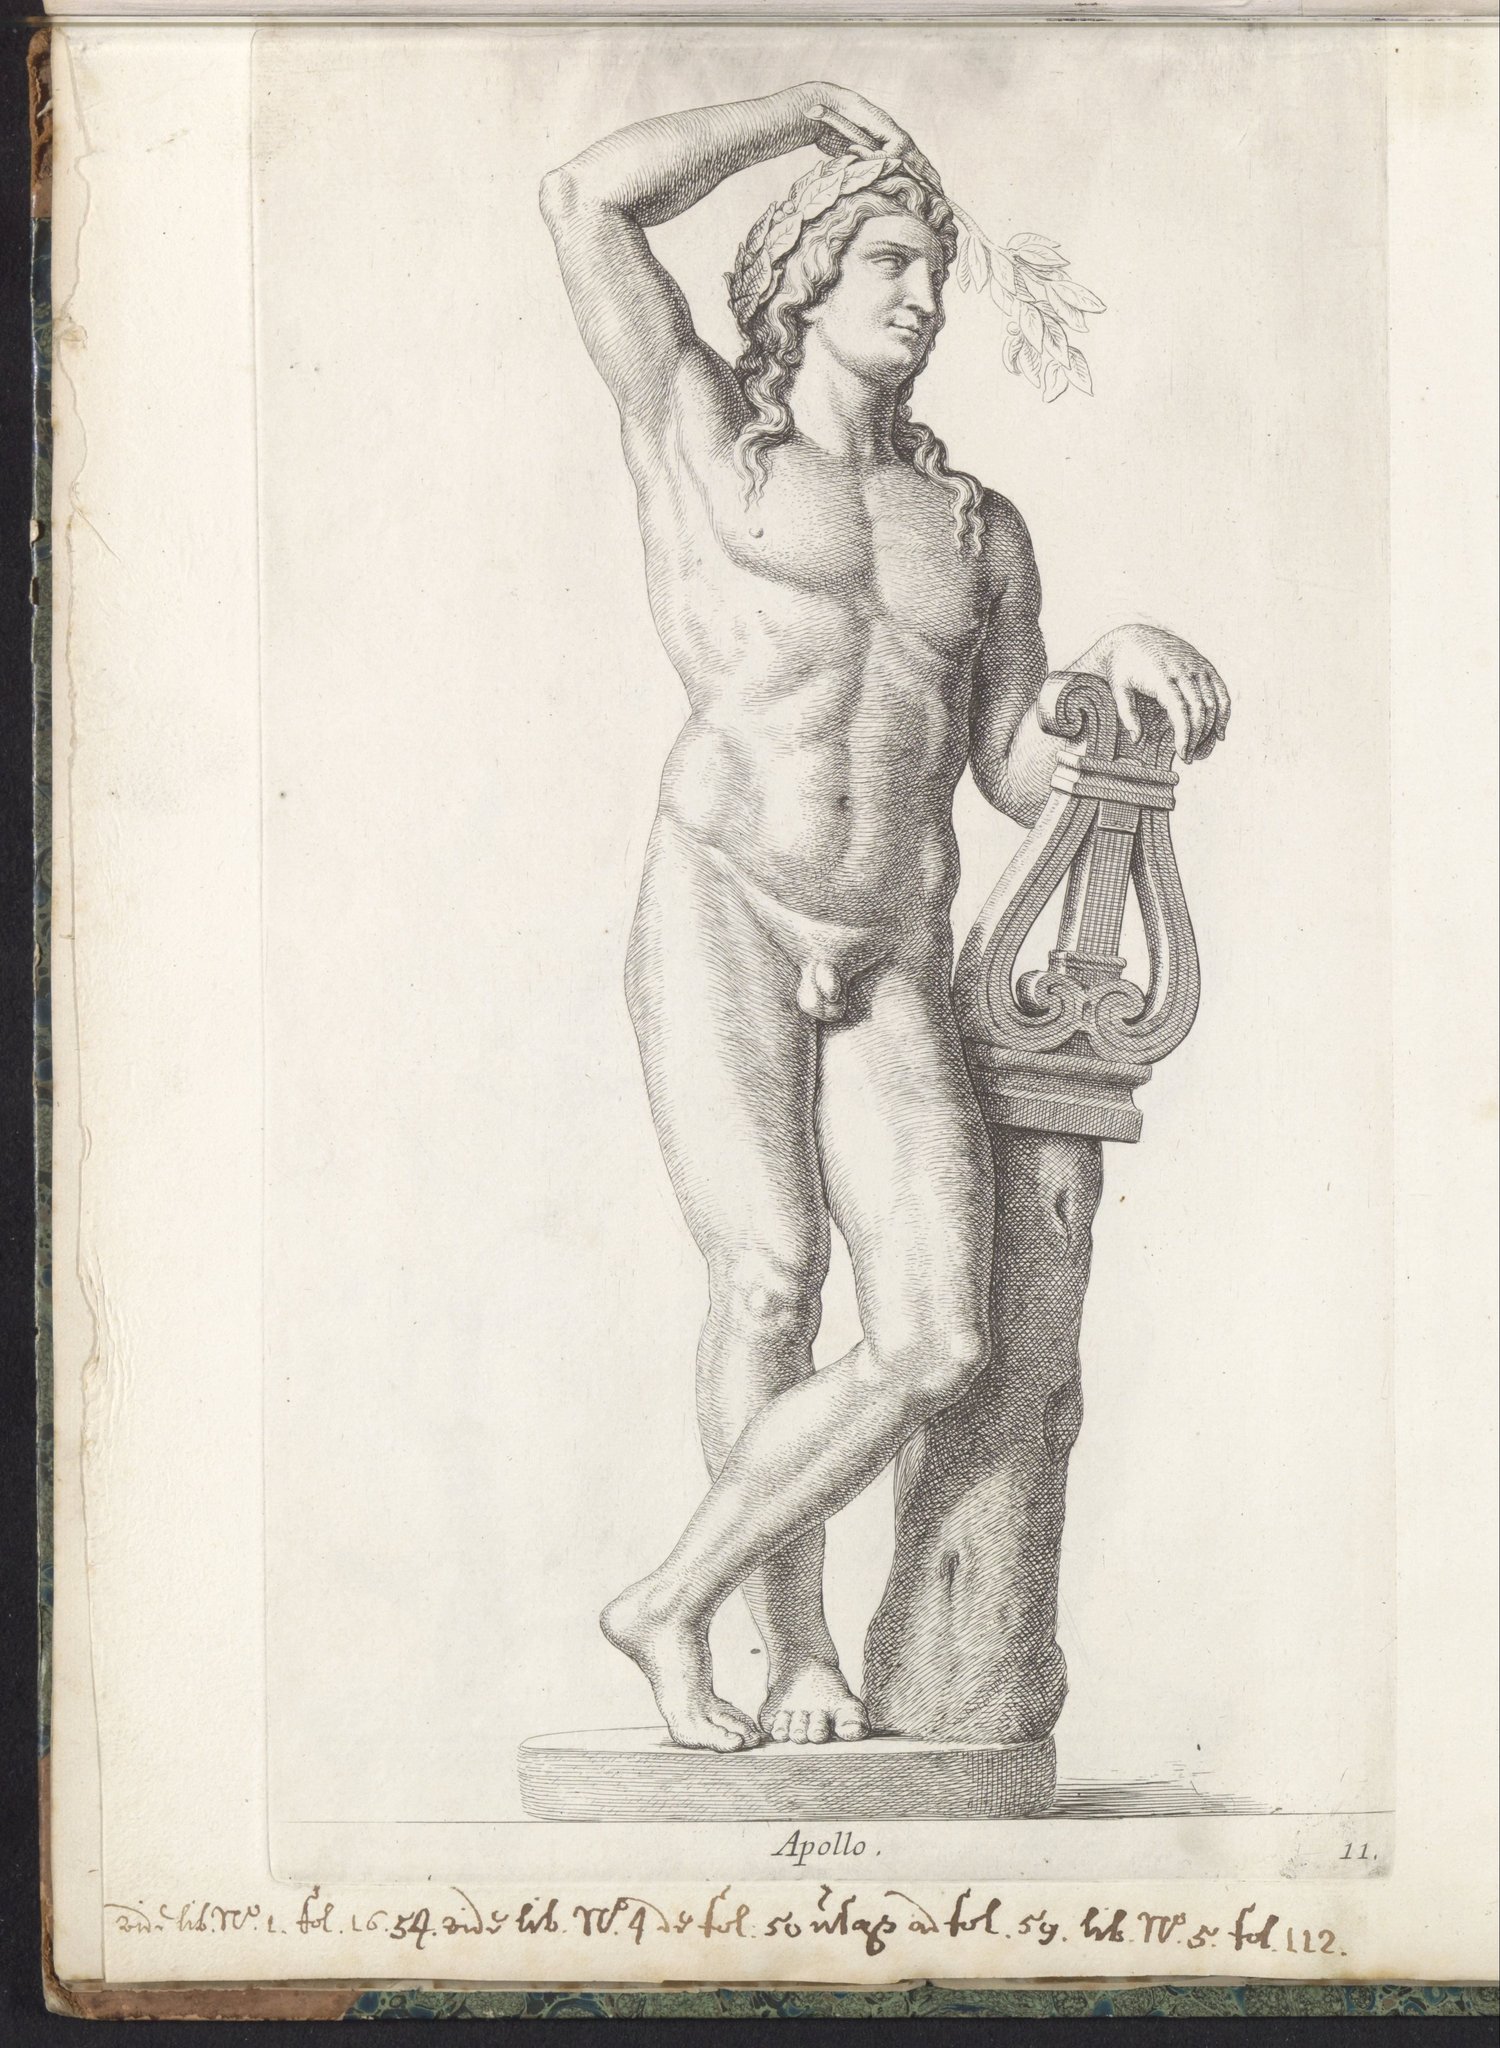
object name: print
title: Apollo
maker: hubert quellinus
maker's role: print maker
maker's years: 1619-1687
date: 1646-1670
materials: paper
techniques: engraving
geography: antwerp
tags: (story of) apollo (phoebus), piece of sculpture, reproduction of a piece of sculpture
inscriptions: inscription: ‘Vide lib. No. 1. fol. 16, 54. Vide lib. No 4de fol. 50 ....’, number: ‘45’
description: Klassieke sculptuur van Apollo leunend op zijn lier. Op zijn hoofd een lauwerkrans en in zijn linkerhand een lauriertak. De prent maakt deel uit van een album met een serie prenten naar de sculpturen in de verzameling van Gerard Reynst.